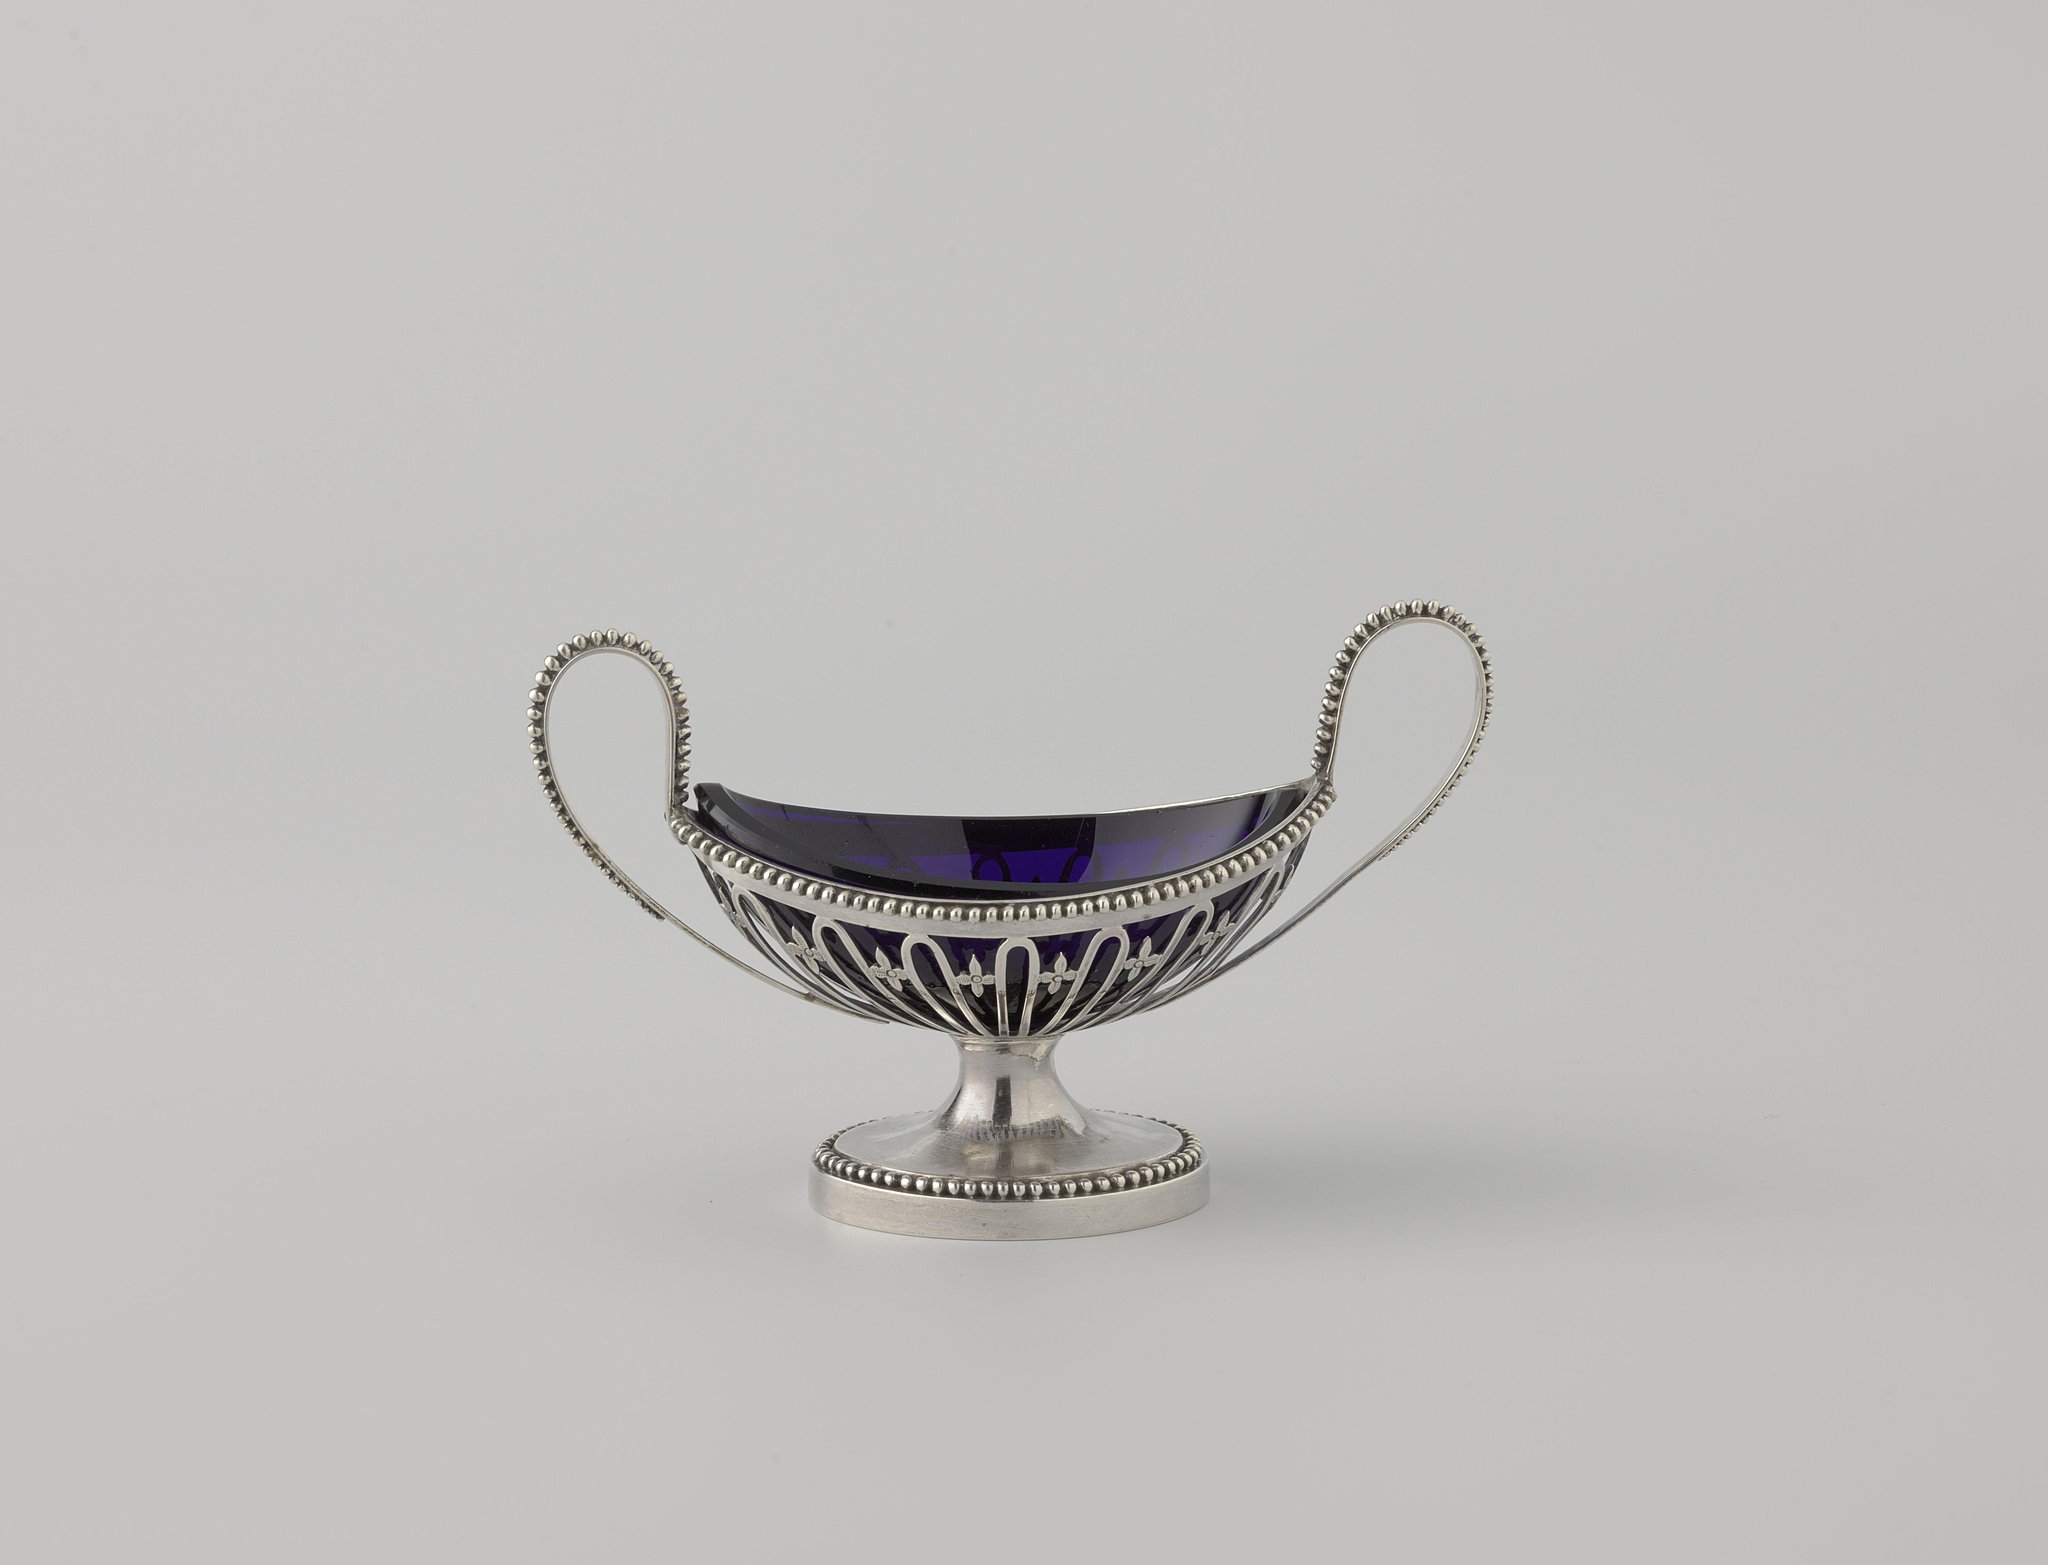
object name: salt condiment vessel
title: Binnenbak van blauw glas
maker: nathanael teuter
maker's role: silversmith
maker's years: 1767-1831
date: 1805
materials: glass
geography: amsterdam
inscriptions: date letter: ‘W’, maker's mark, duty mark, town mark, alloy mark